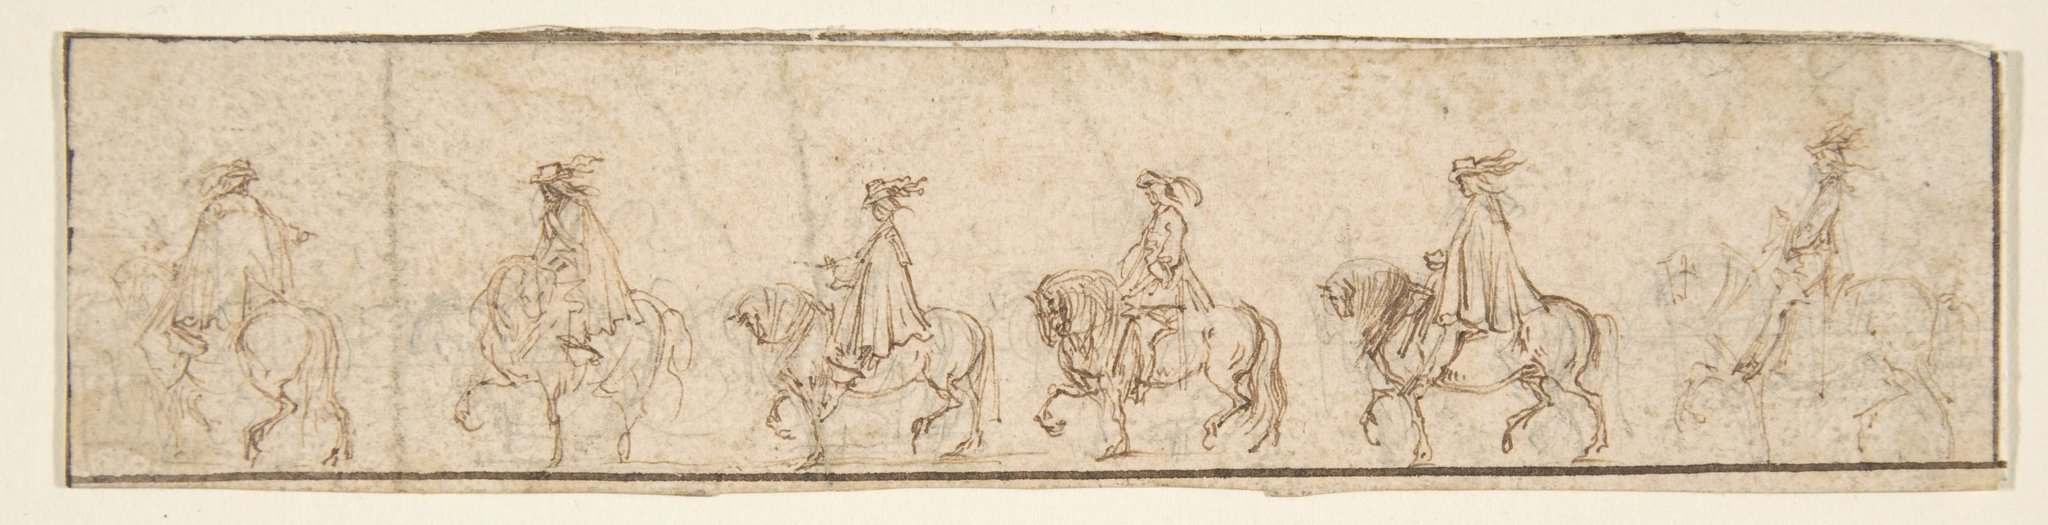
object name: drawing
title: Procession of Six Horsemen in Profile View Facing Left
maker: stefano della bella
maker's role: artist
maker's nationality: italian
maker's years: 1610-1664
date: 1610-1664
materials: graphite, ink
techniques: pen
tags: horses